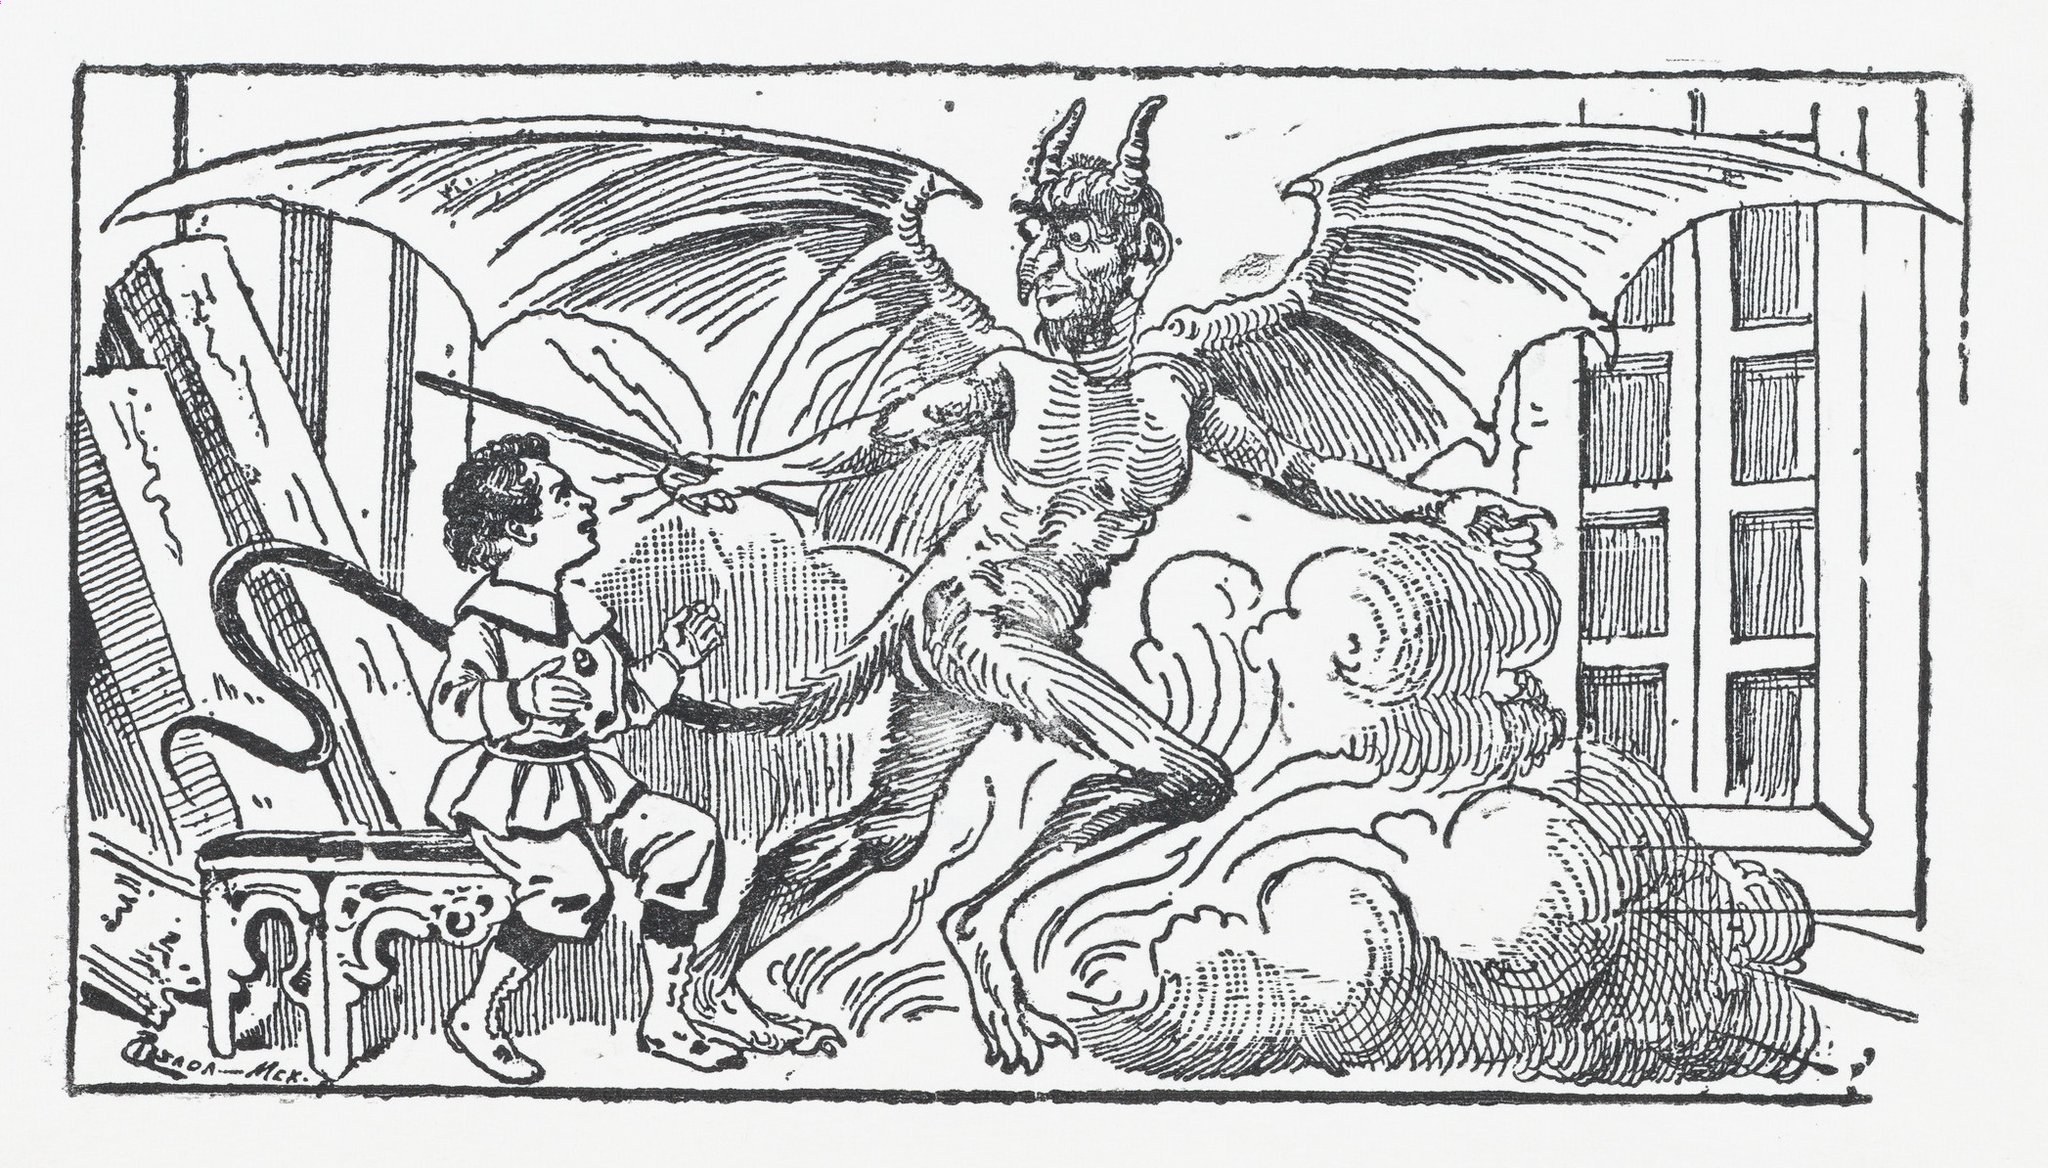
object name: print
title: A young boy cowering from a demon, illustration from 'El cuento Nniño de los dulces'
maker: josé guadalupe posada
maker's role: artist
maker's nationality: mexican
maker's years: 1852-1913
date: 1880-1910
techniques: lithography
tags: fear,boys,demons